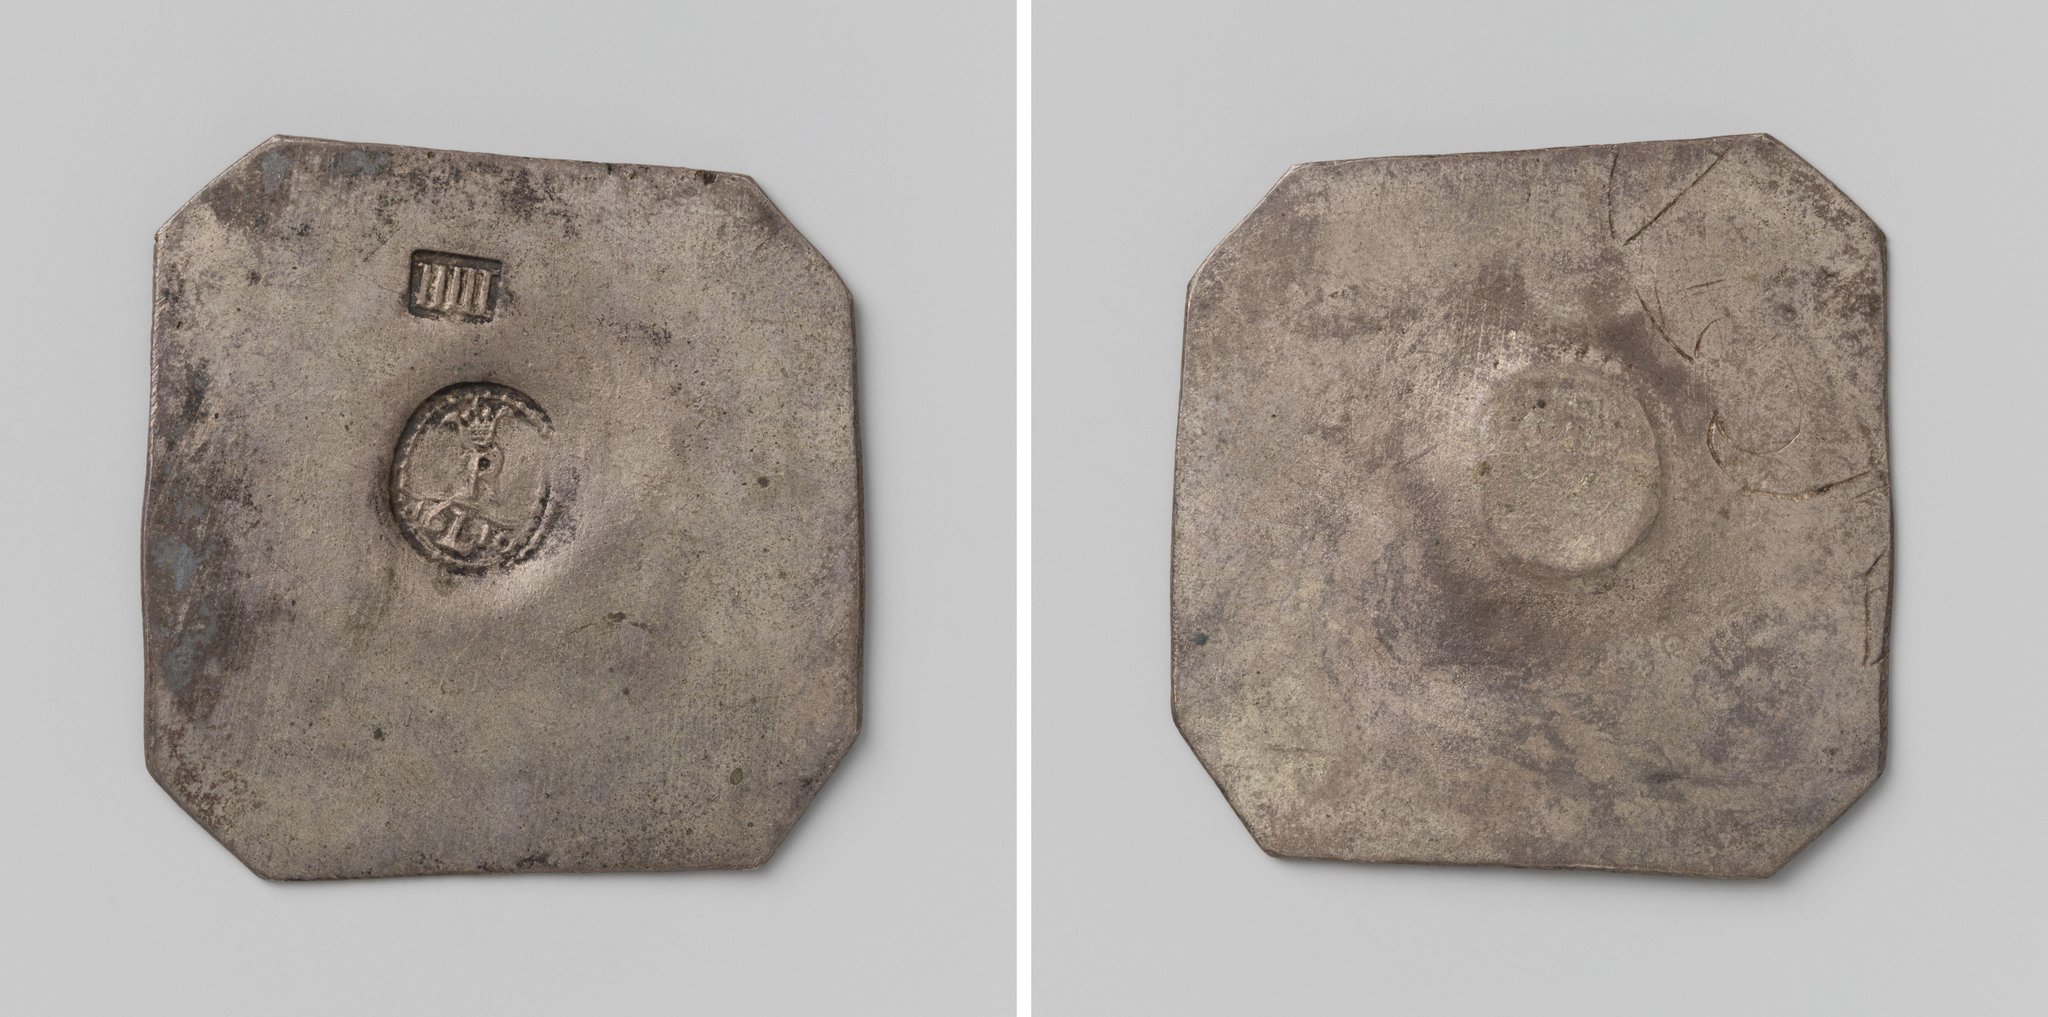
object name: coin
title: Vijf eenheden, noodmunt uit Gulik, geslagen tijdens het beleg door Maurits, prins van Oranje-Nassau, vervaardigd door stuk te knippen uit bord of kom en bestempeld met het monogram van Rudolf II, Duits keizer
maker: Anonymous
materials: silver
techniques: striking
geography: gulik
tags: the hague, maurice (prince of orange), vienna, prague, rudolf ii van habsburg (duits keizer)